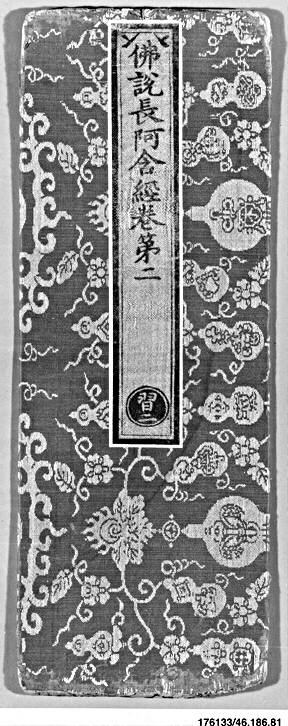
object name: sutra cover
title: Sutra Cover with Gourds on a Vine Scroll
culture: chinese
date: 1501-1600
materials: silk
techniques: patterning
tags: flowers,vines